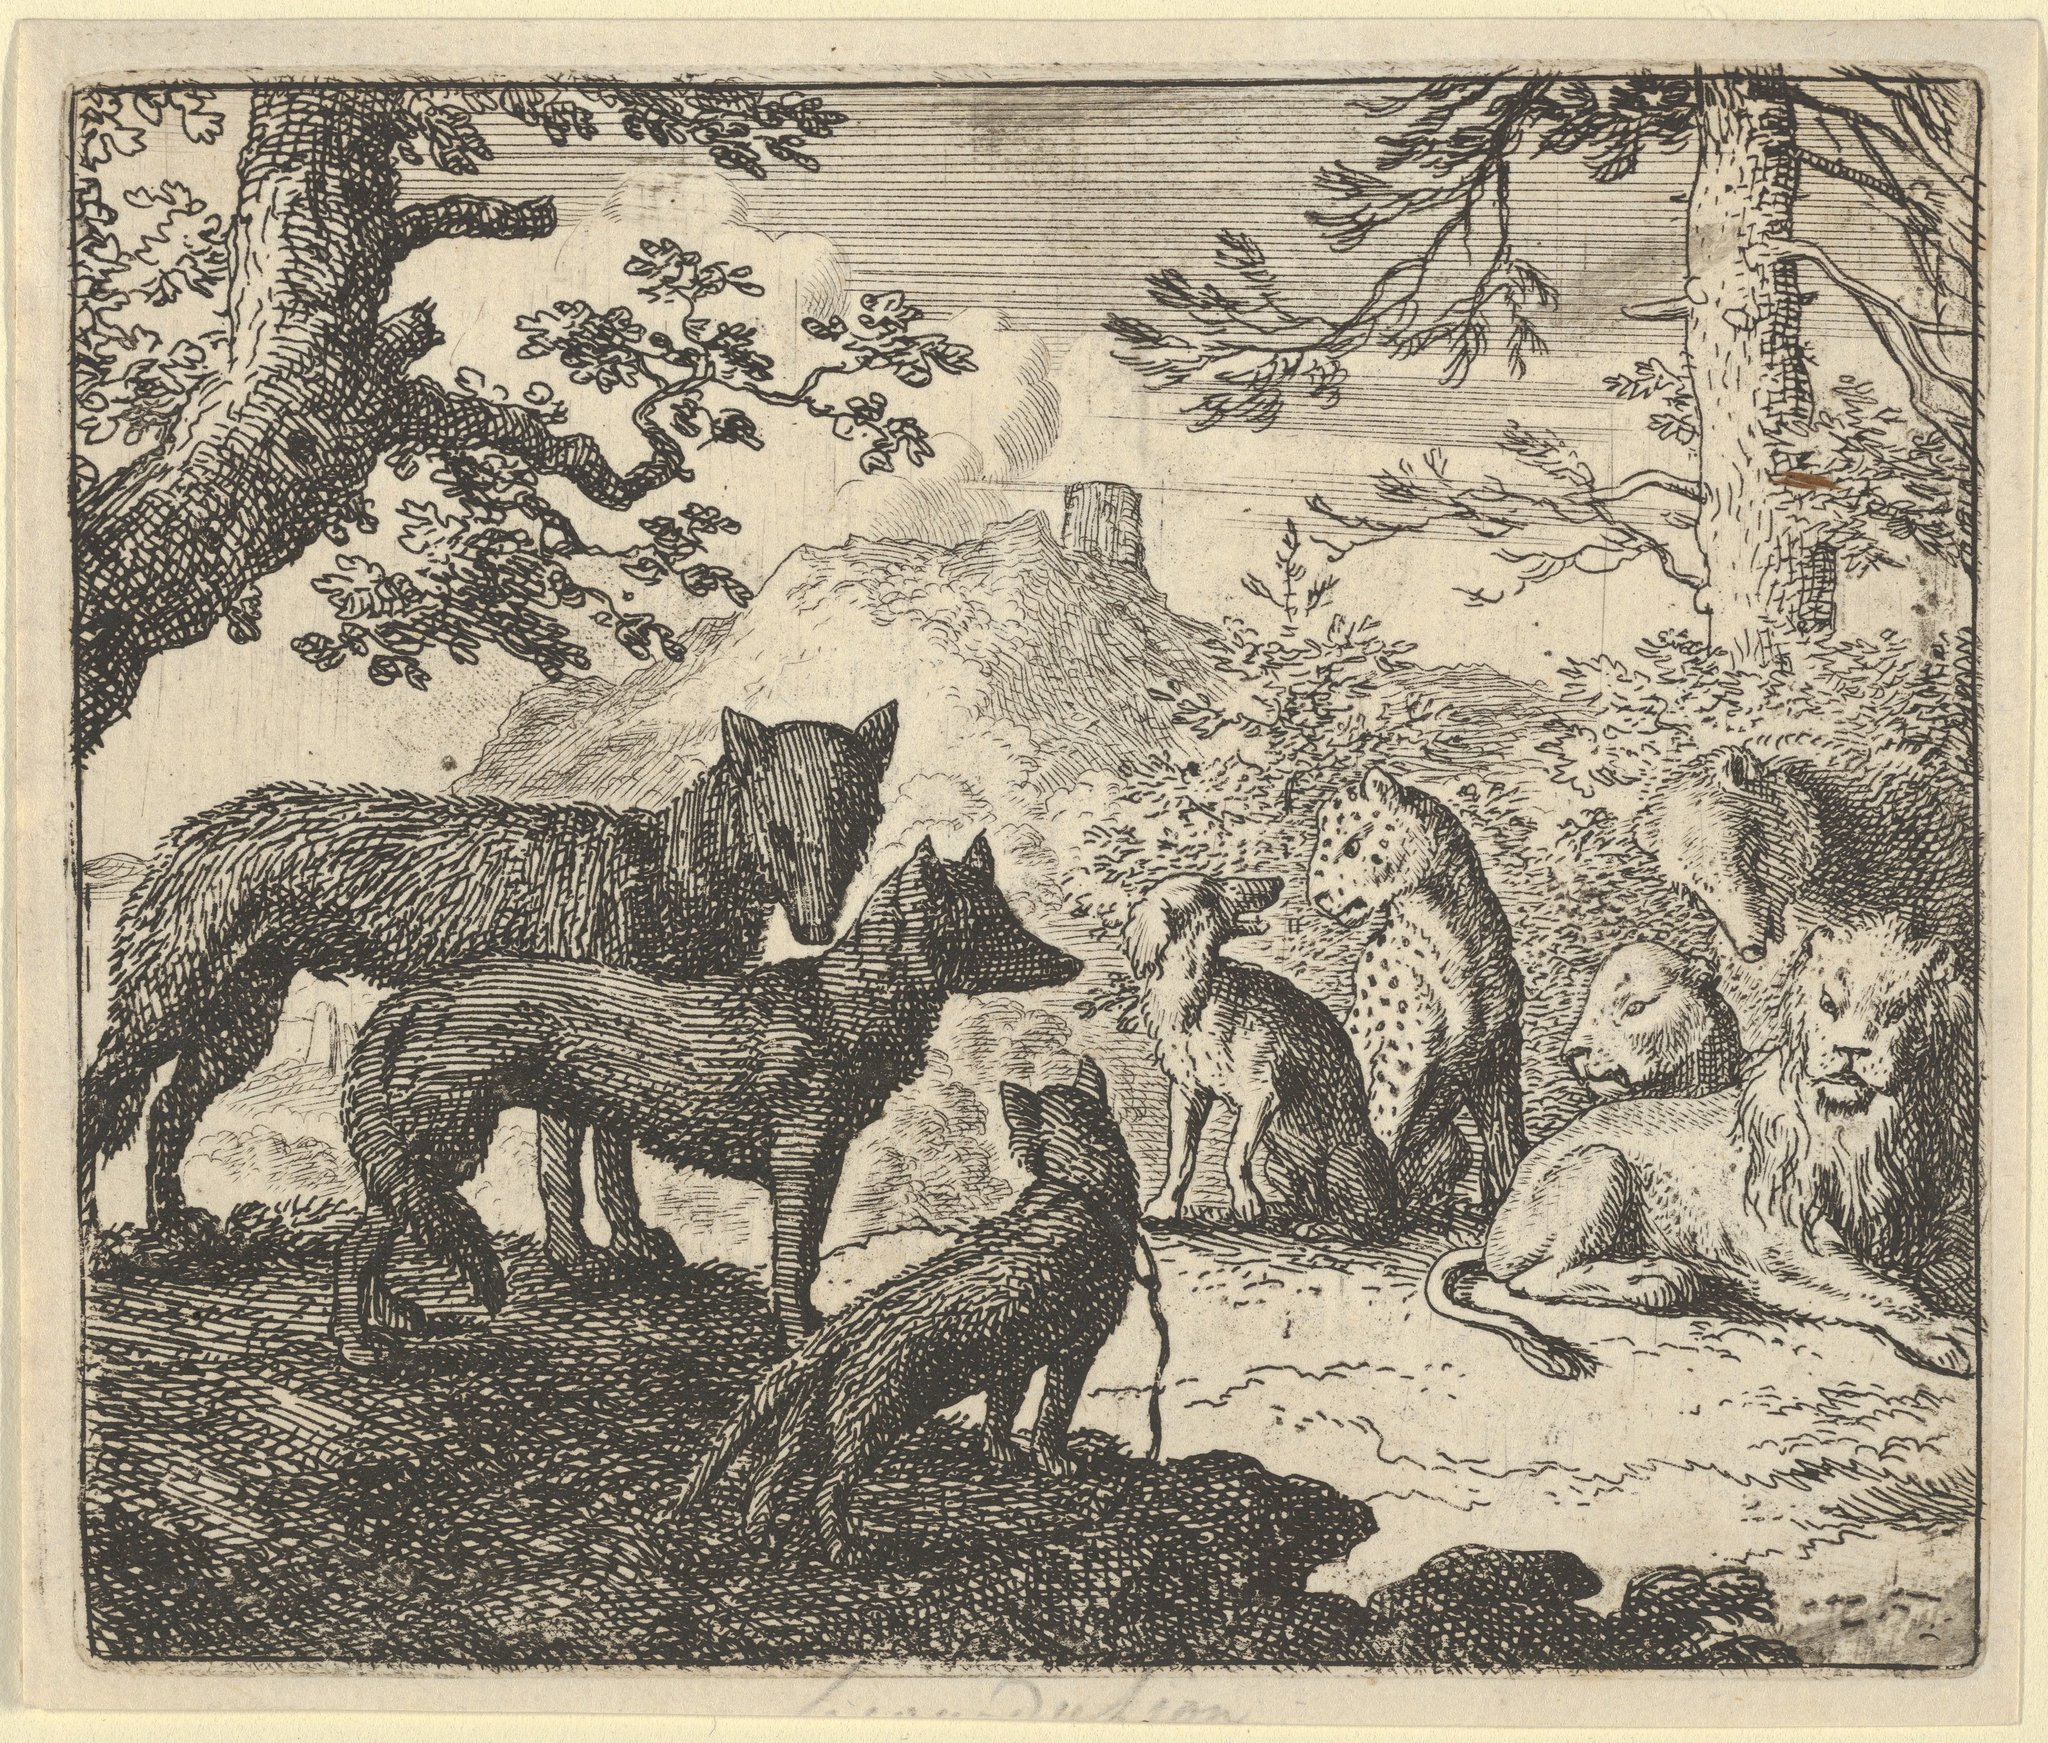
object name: print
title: Renard's Parents Ask to Withdraw from the Court from Hendrick van Alcmar's Renard The Fox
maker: allart van everdingen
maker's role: artist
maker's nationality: dutch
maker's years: 1621-1675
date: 1650-1675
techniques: engraving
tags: bears,foxes,leopards,lions,forests